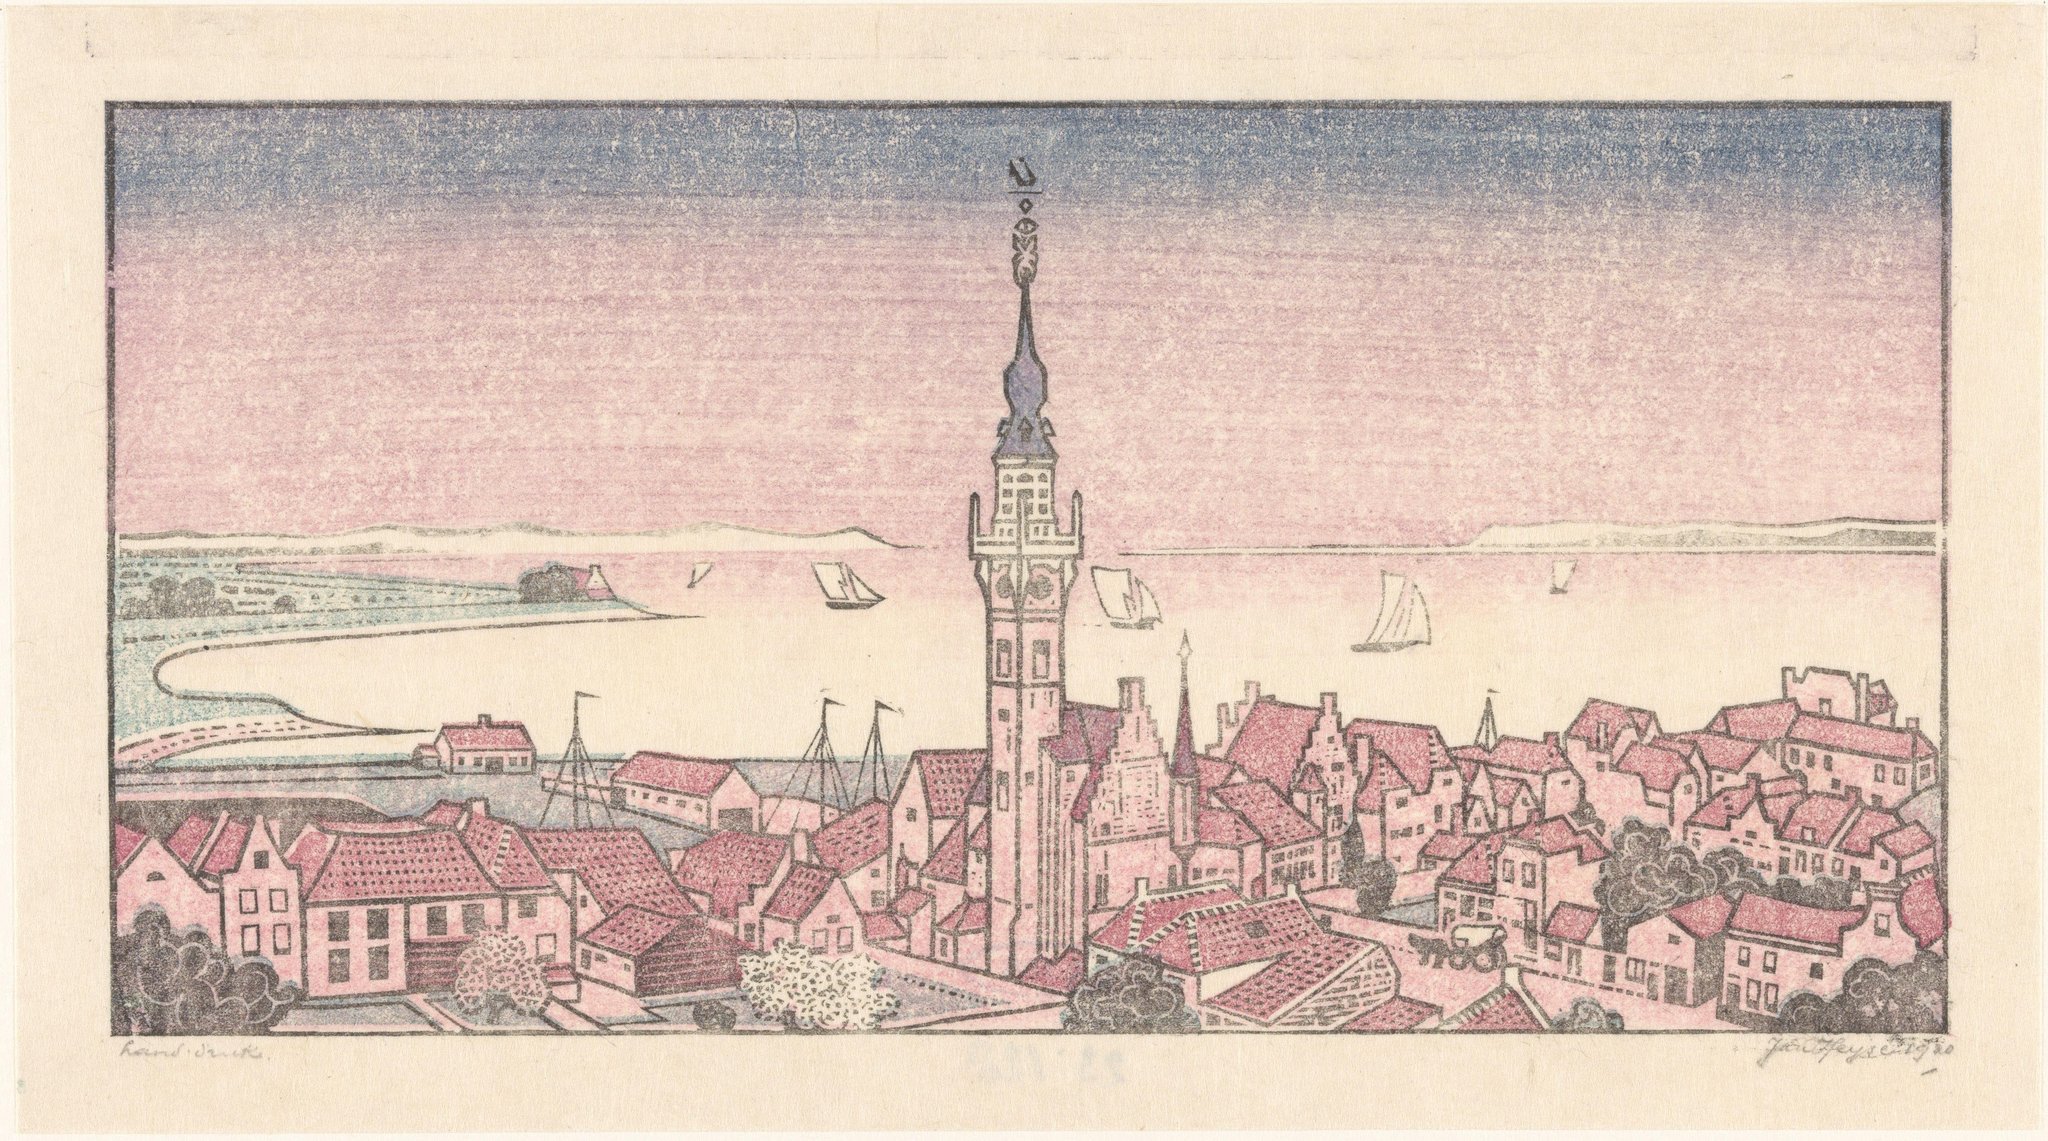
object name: print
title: Gezicht op Veere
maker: jan heyse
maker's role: painter, print maker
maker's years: 1882-1954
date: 1920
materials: paper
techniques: woodcut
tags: village, lake, townhall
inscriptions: collector's mark: Lugt 2228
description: In het midden het stadhuis. Op de achtergrond het Veerse Gat met zeilboten.